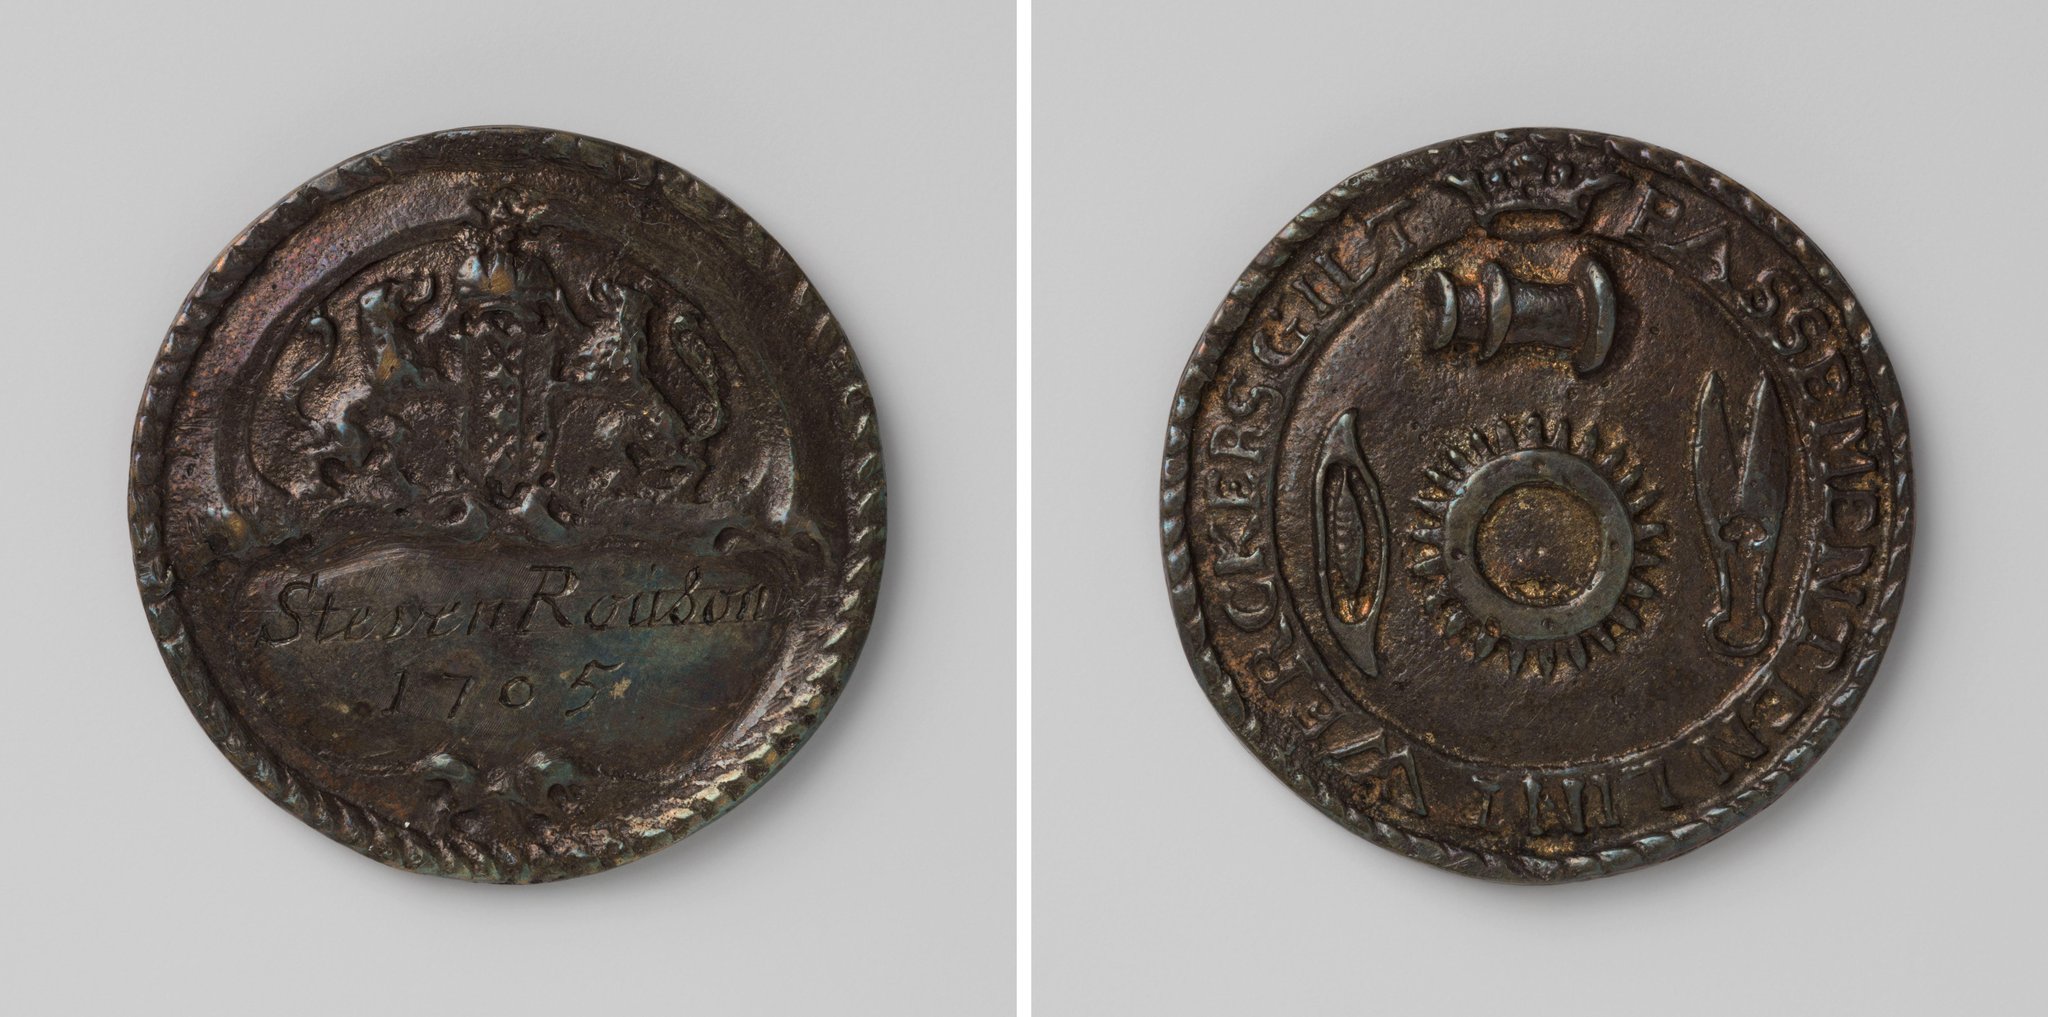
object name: medal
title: Passement- en lintwerkersgilde van Amsterdam, gildepenning van Steven Rouson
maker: Anonymous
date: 1705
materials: brass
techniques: casting, engraving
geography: amsterdam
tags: amsterdam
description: Guilds were urban organisations of people in specific occupations. The guild represented the interests of the profession. Each member had a token as proof of membership. The person’s name was engraved on one side of the token, often together with the arms of the guild or of the city in which it was based. The other side carried a motif signifying the occupation represented by the guild.